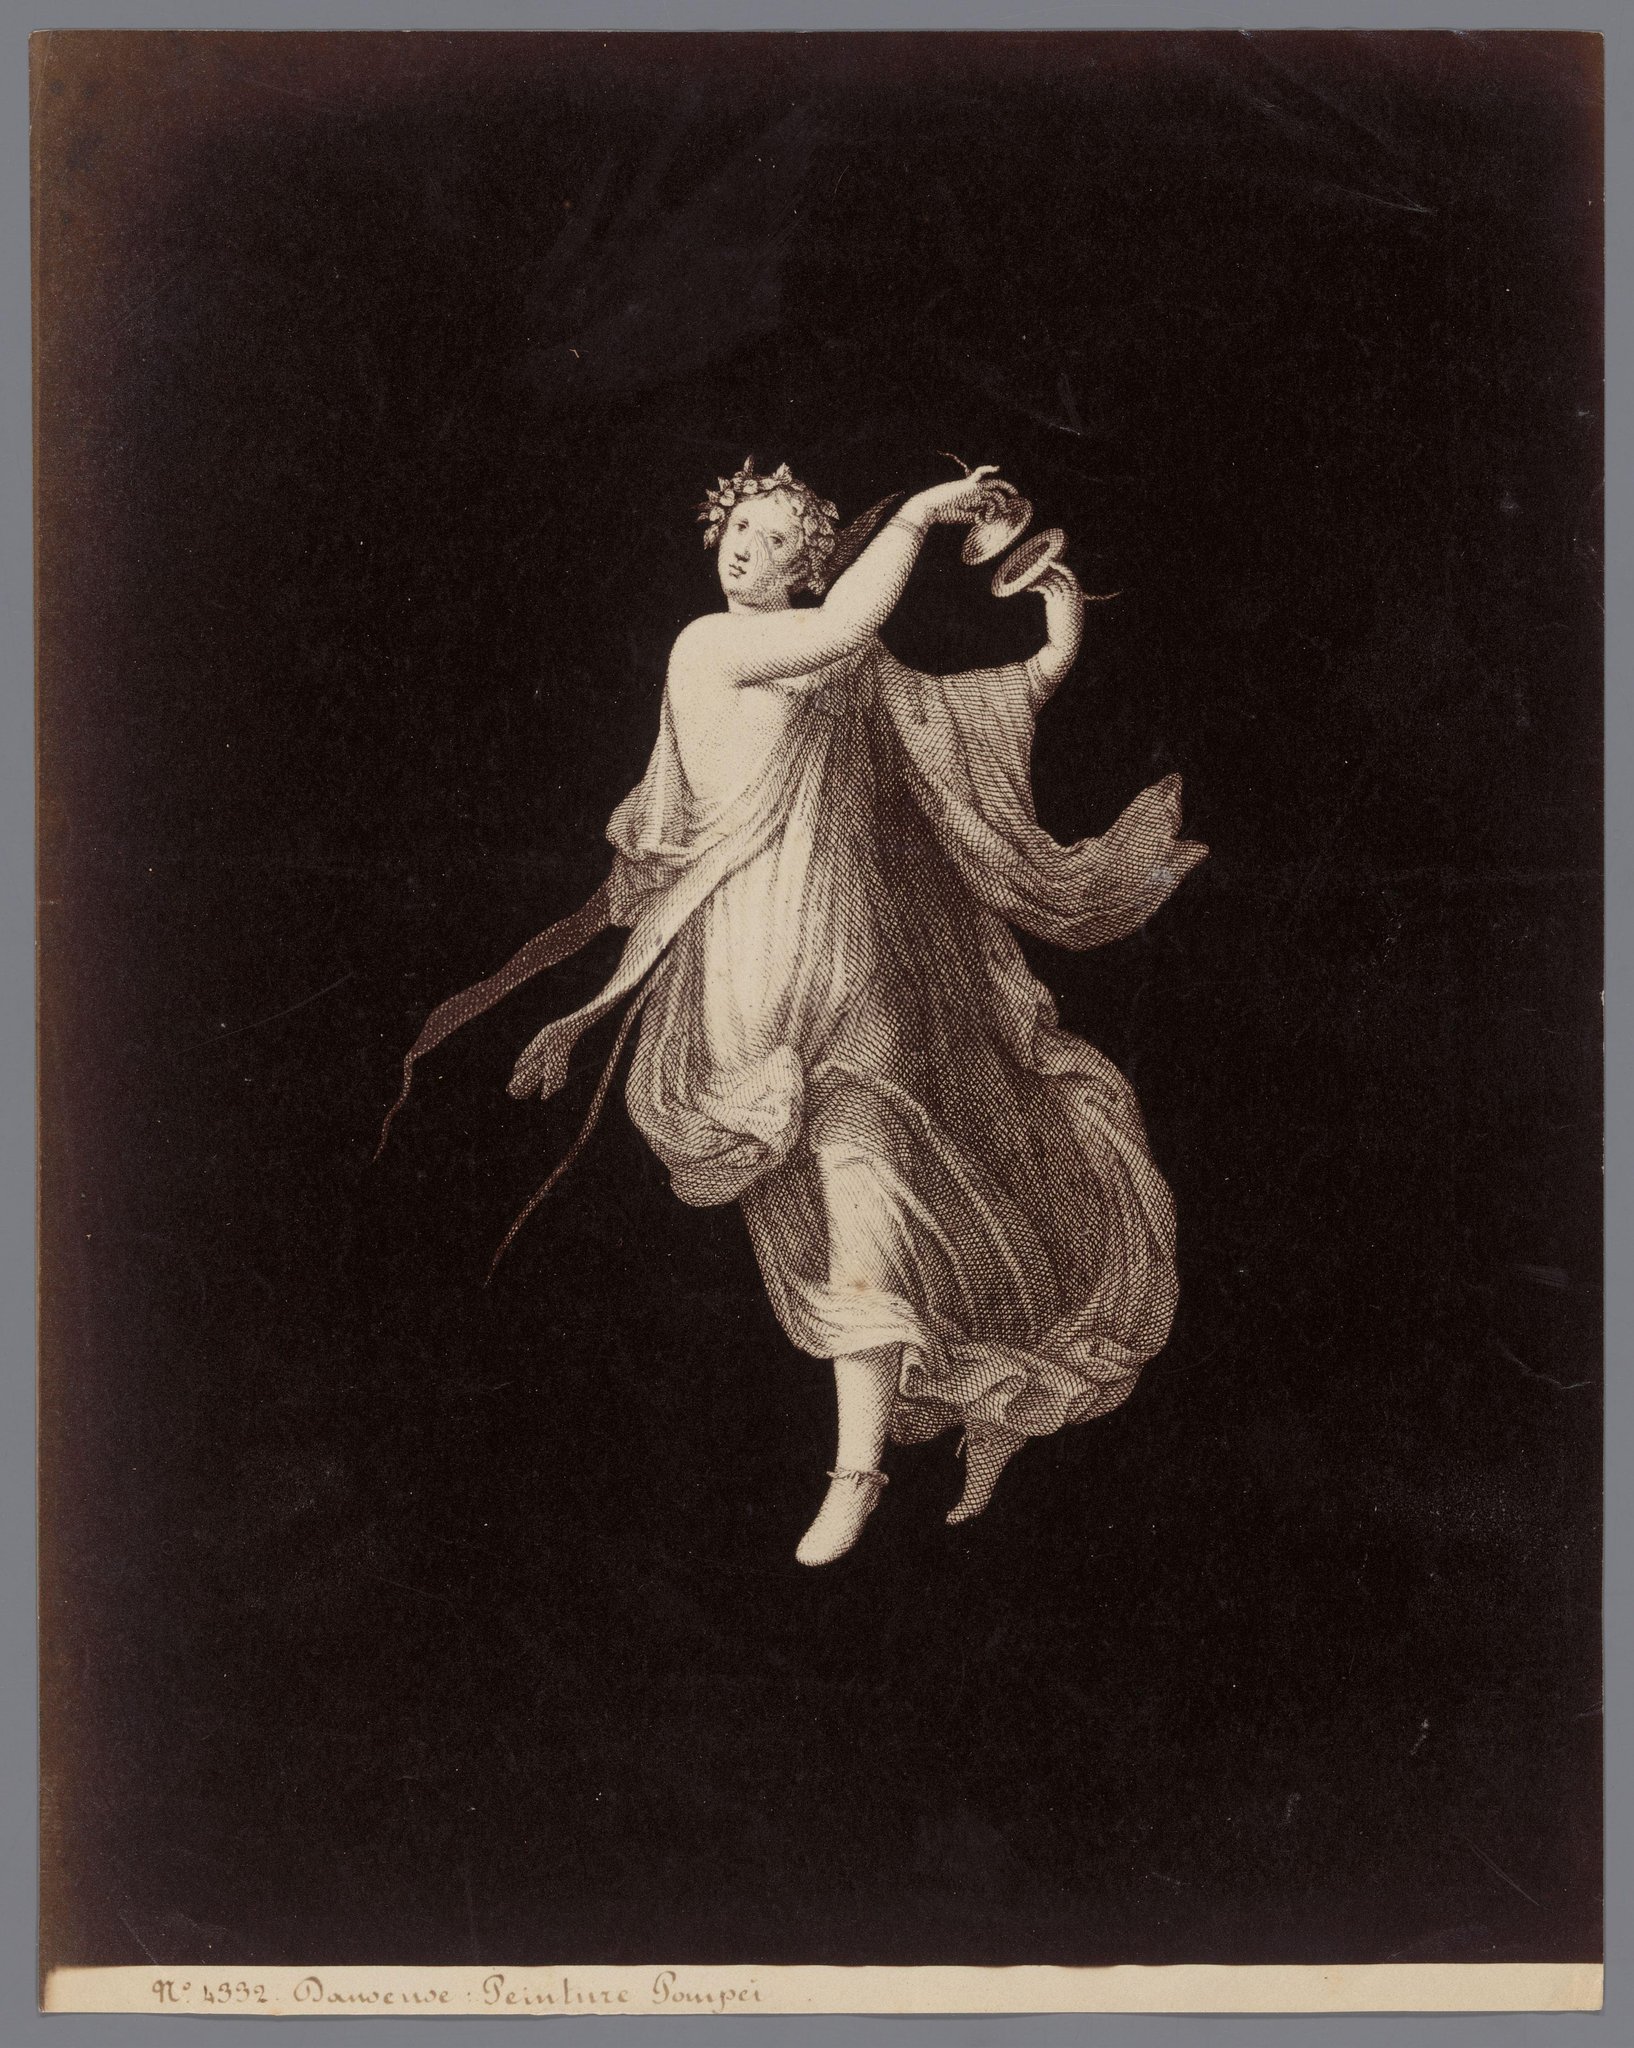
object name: photograph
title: Fotoreproductie van een gravure naar een fresco van een danseres in Pompeï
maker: Anonymous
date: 1870-1890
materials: paper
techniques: albumen print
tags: print, e.g.: engraving, etching, lithograph, picture, painting, pompeii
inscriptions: number: ‘No. 4332.’, collector's mark: ‘VOSMAER’